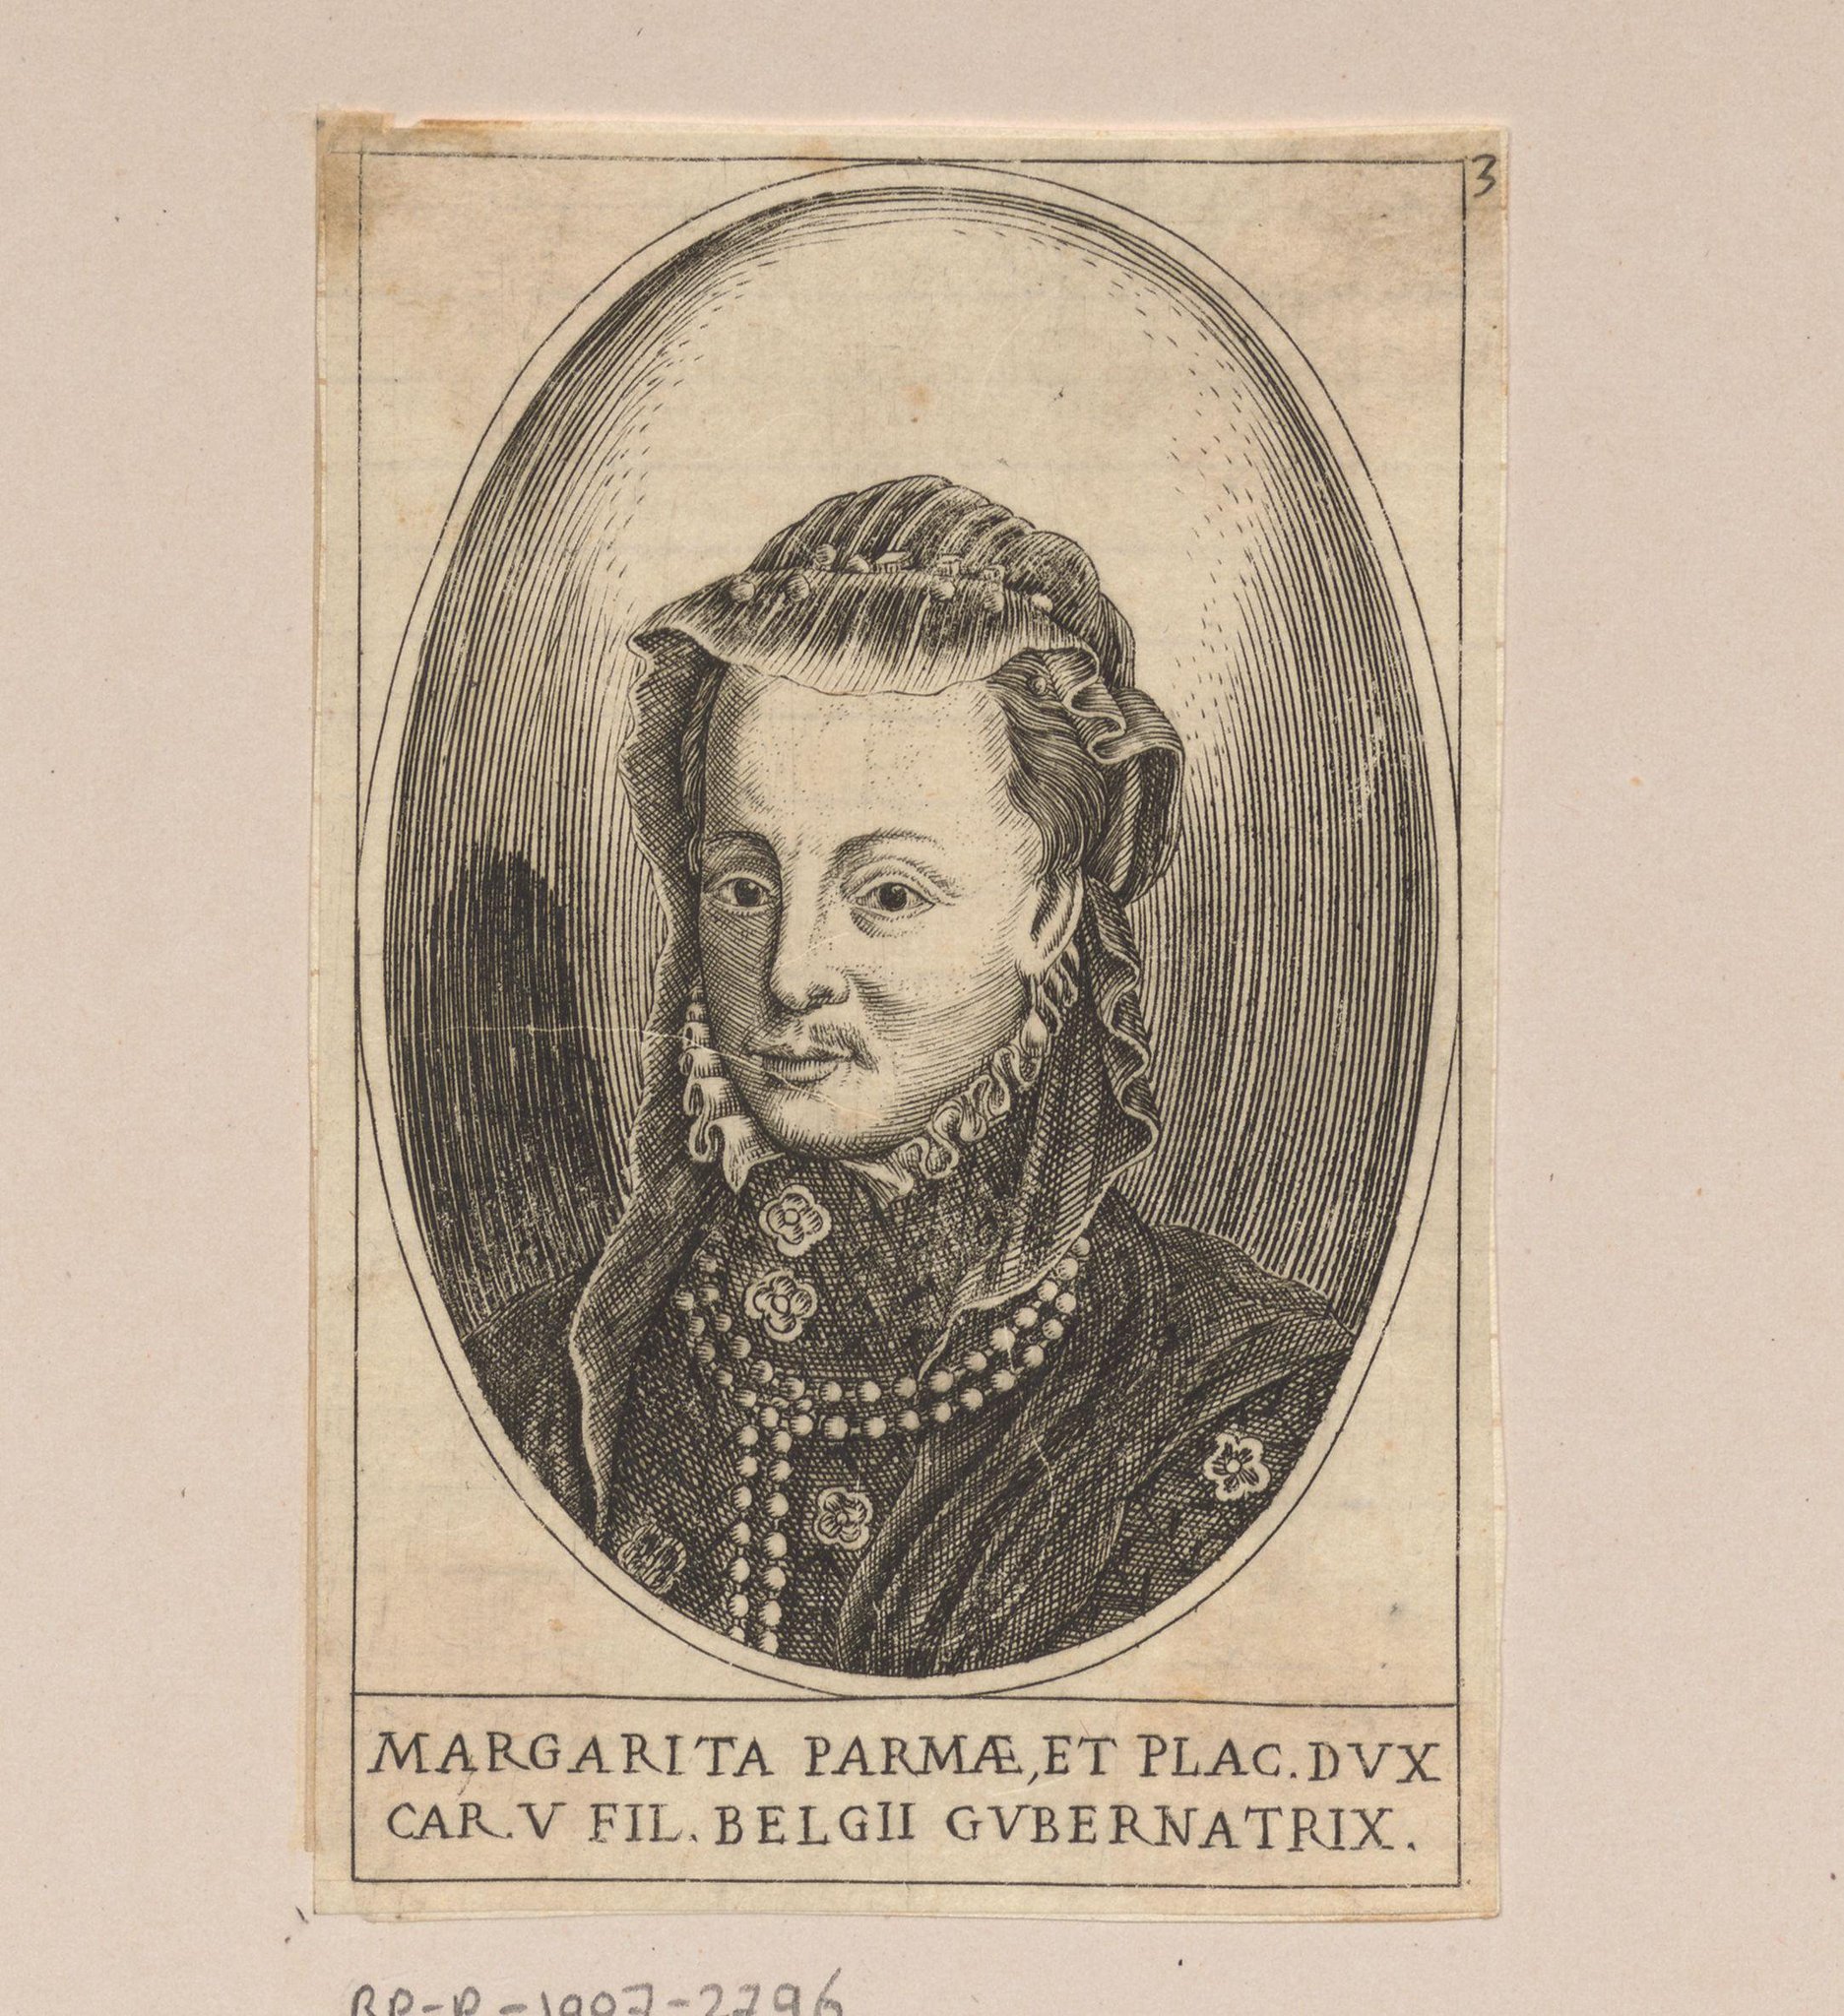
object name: print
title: Portret van Margaretha van Parma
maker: Anonymous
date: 1620-1670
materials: paper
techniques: engraving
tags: historical persons - bb - woman, regent, substitute ruler; viceroy - bb - female ruler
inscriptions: collector's mark: Lugt 2228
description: Met tweeregelig onderschrift in het Latijn.